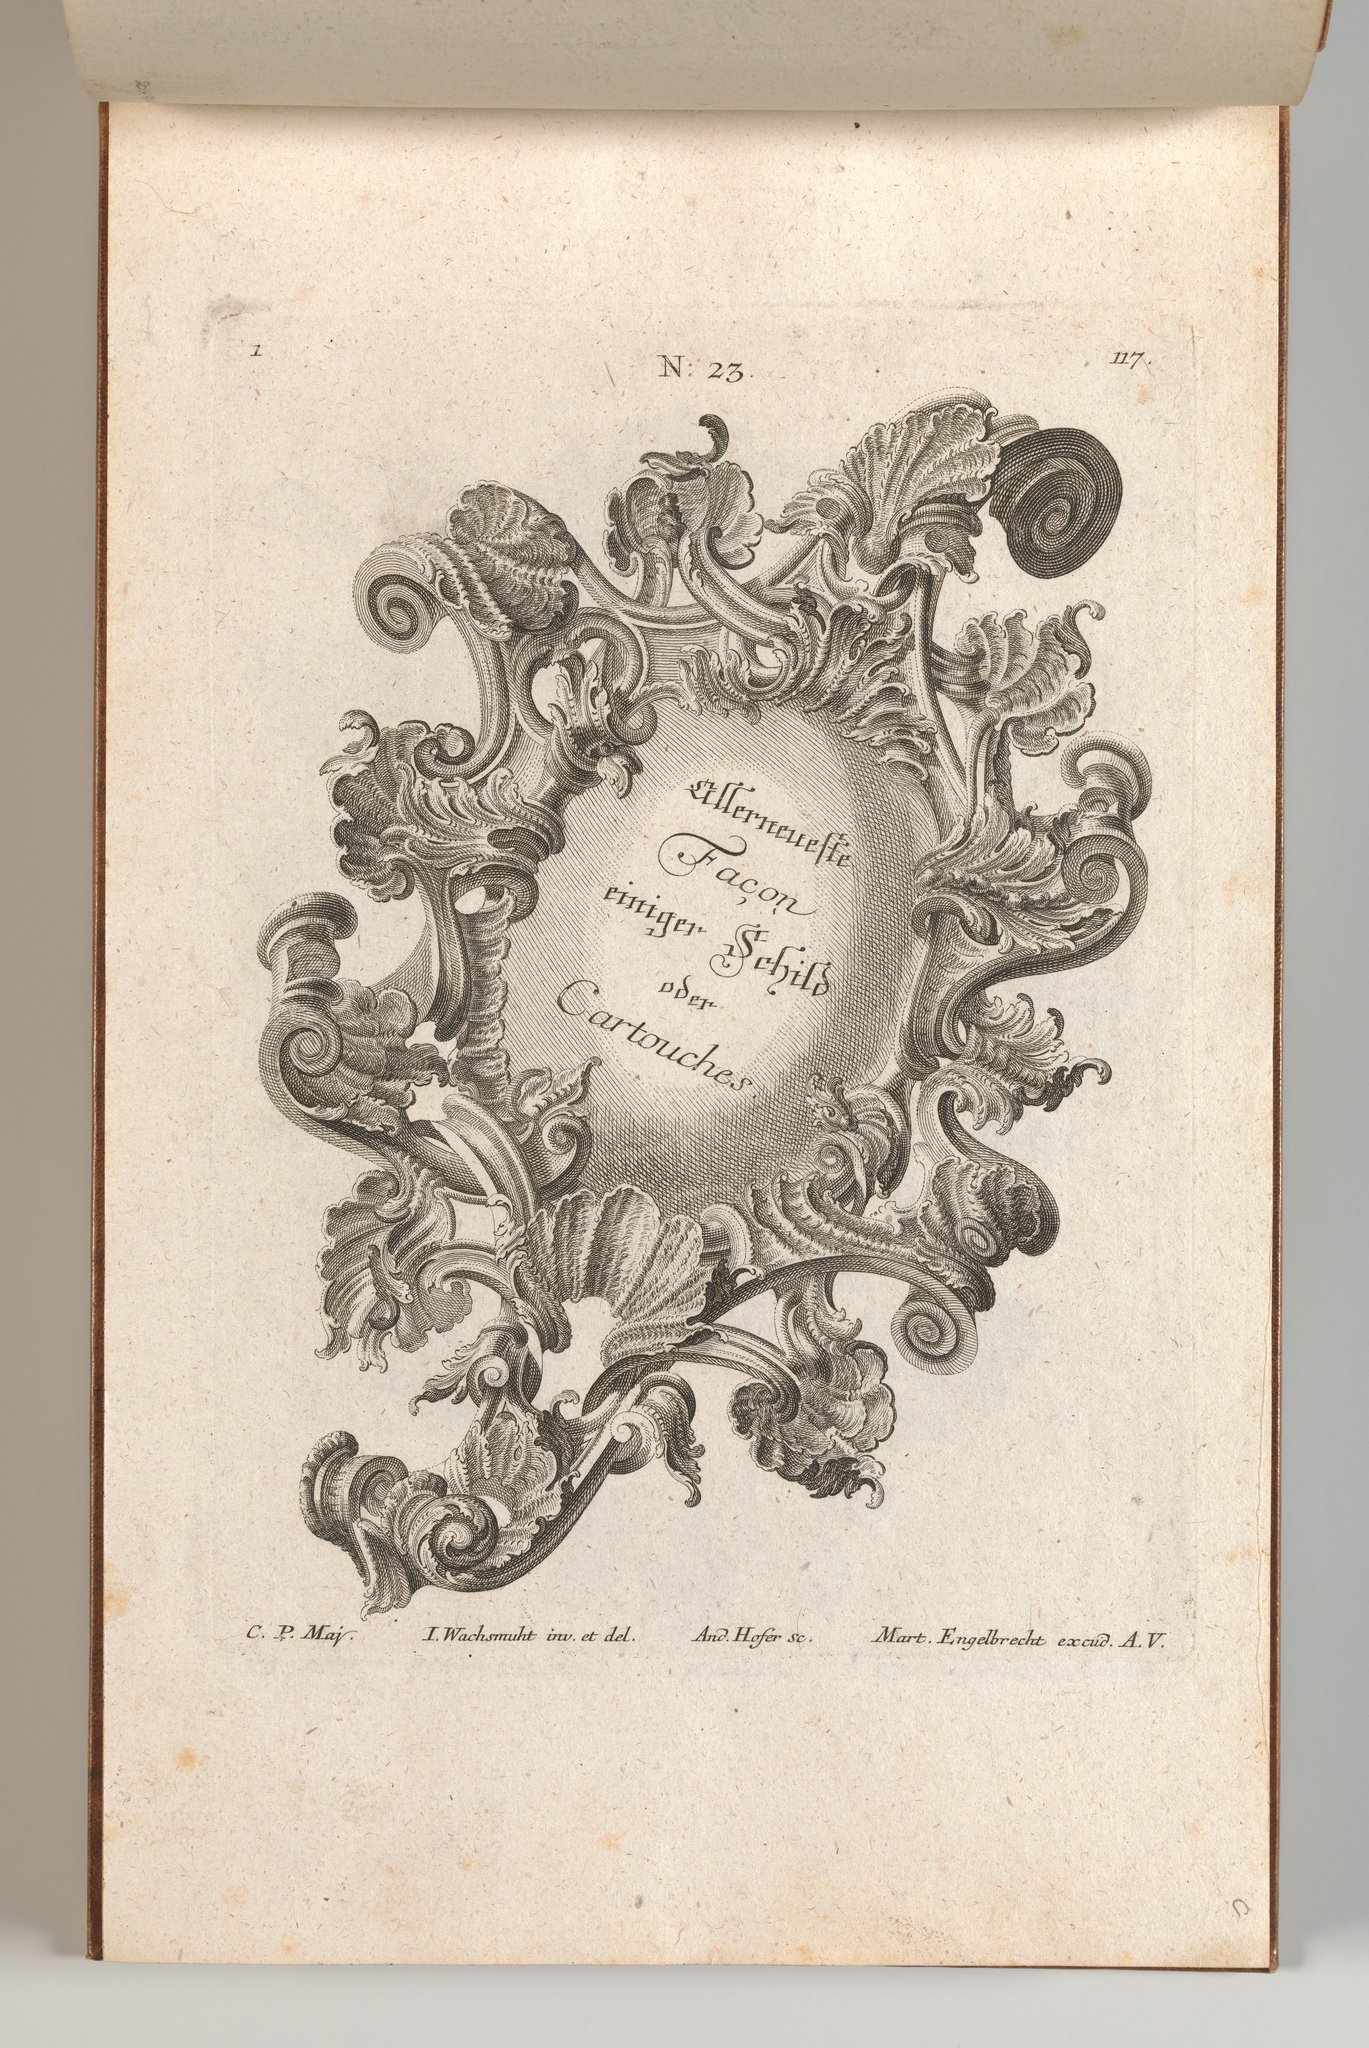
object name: album print ornament architecture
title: Design for a Cartouche, Plate 1 from 'Allerneueste Façon einiger Schild oder Cartouches'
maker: andreas hofer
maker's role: engraver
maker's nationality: central european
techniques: etching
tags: cartouches